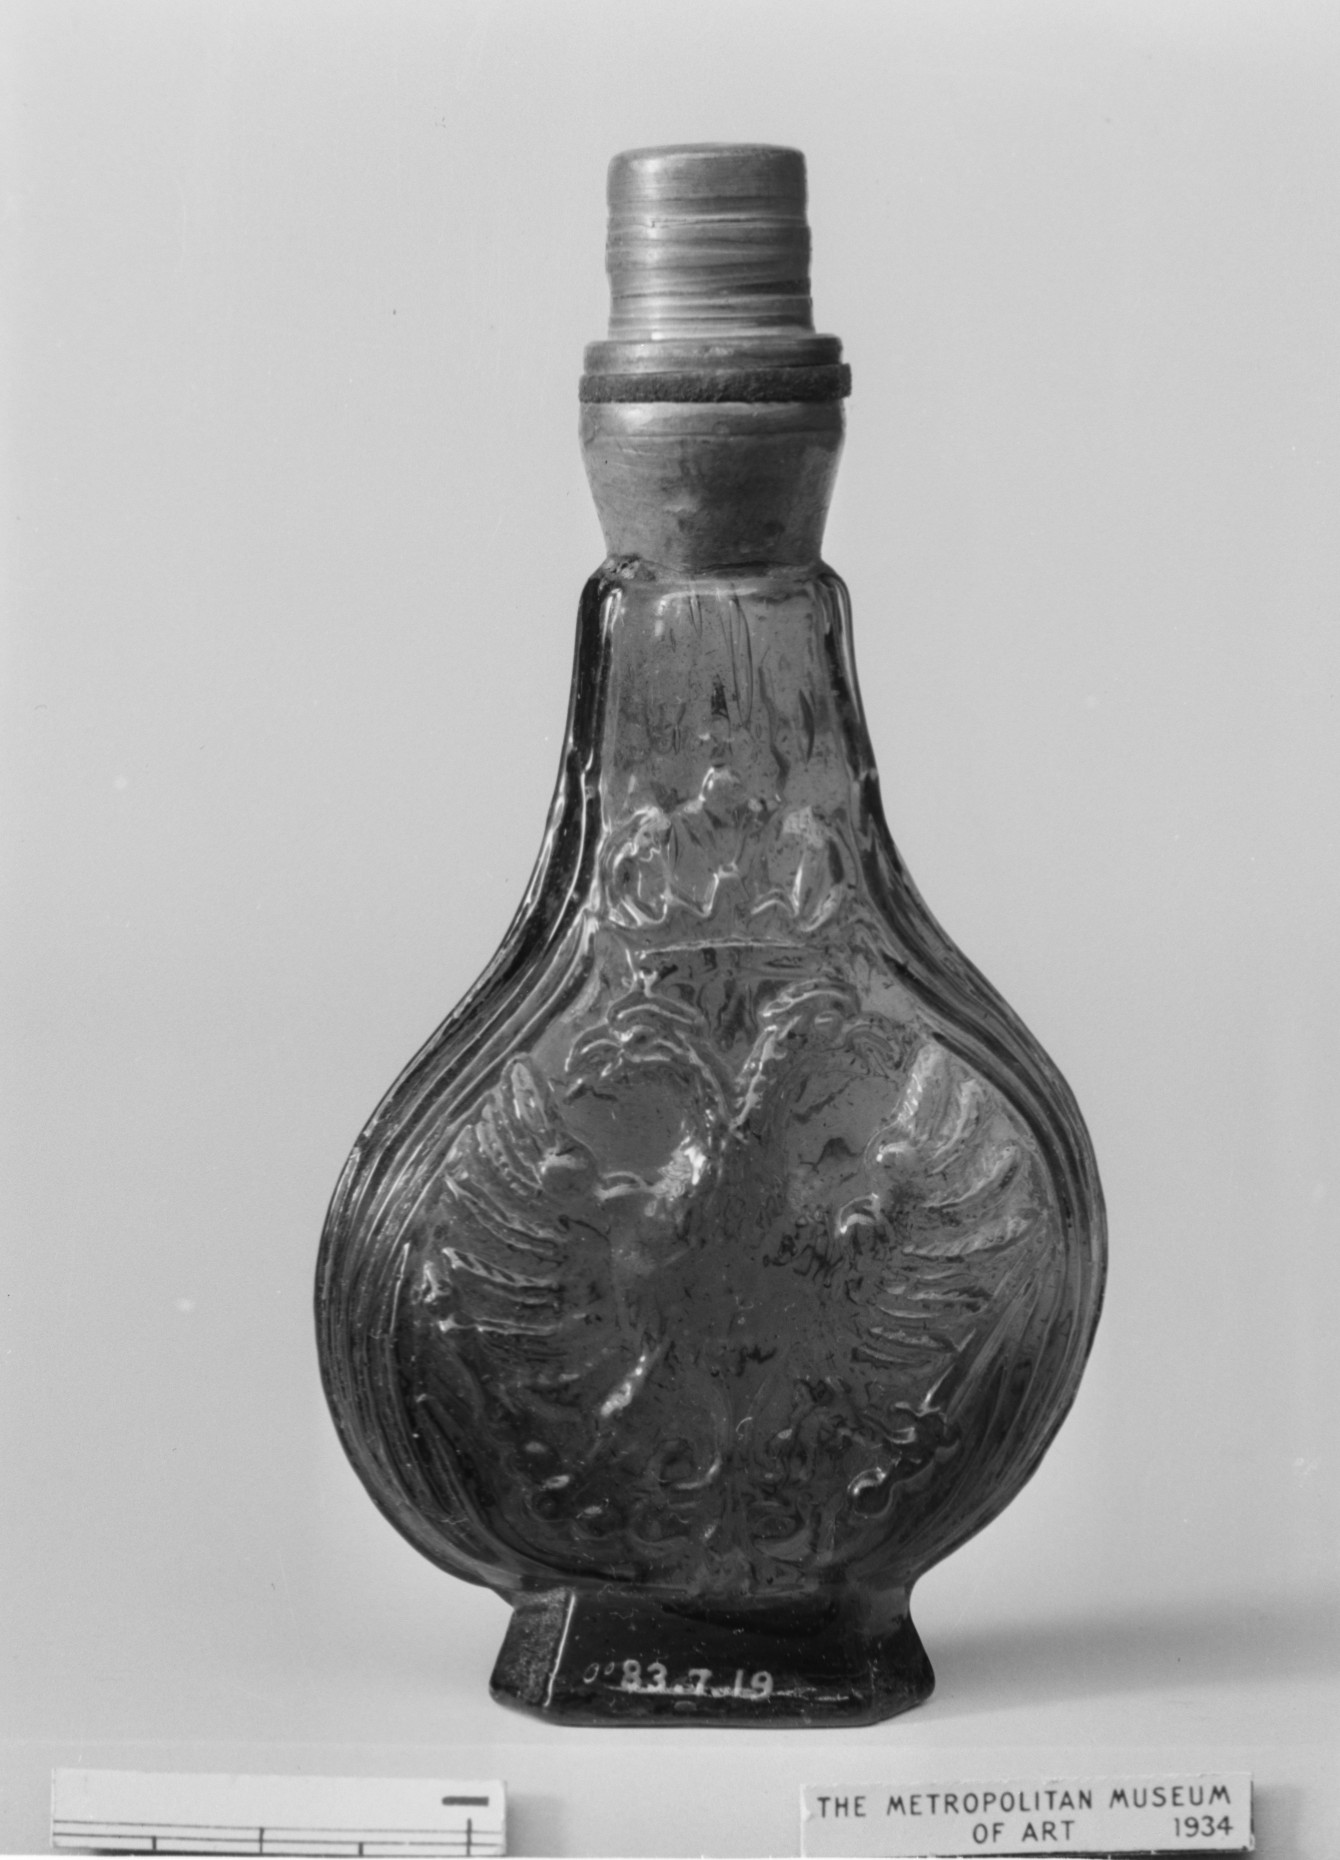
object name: scent bottle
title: Amethyst-colored flacon de poche decorated with imperial eagle and floral bouquet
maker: glasshouse of bernard perrot, verrerie royale d'orléans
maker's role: maker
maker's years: 1640-1709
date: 1701-1800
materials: glass, pewter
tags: eagles,insignia